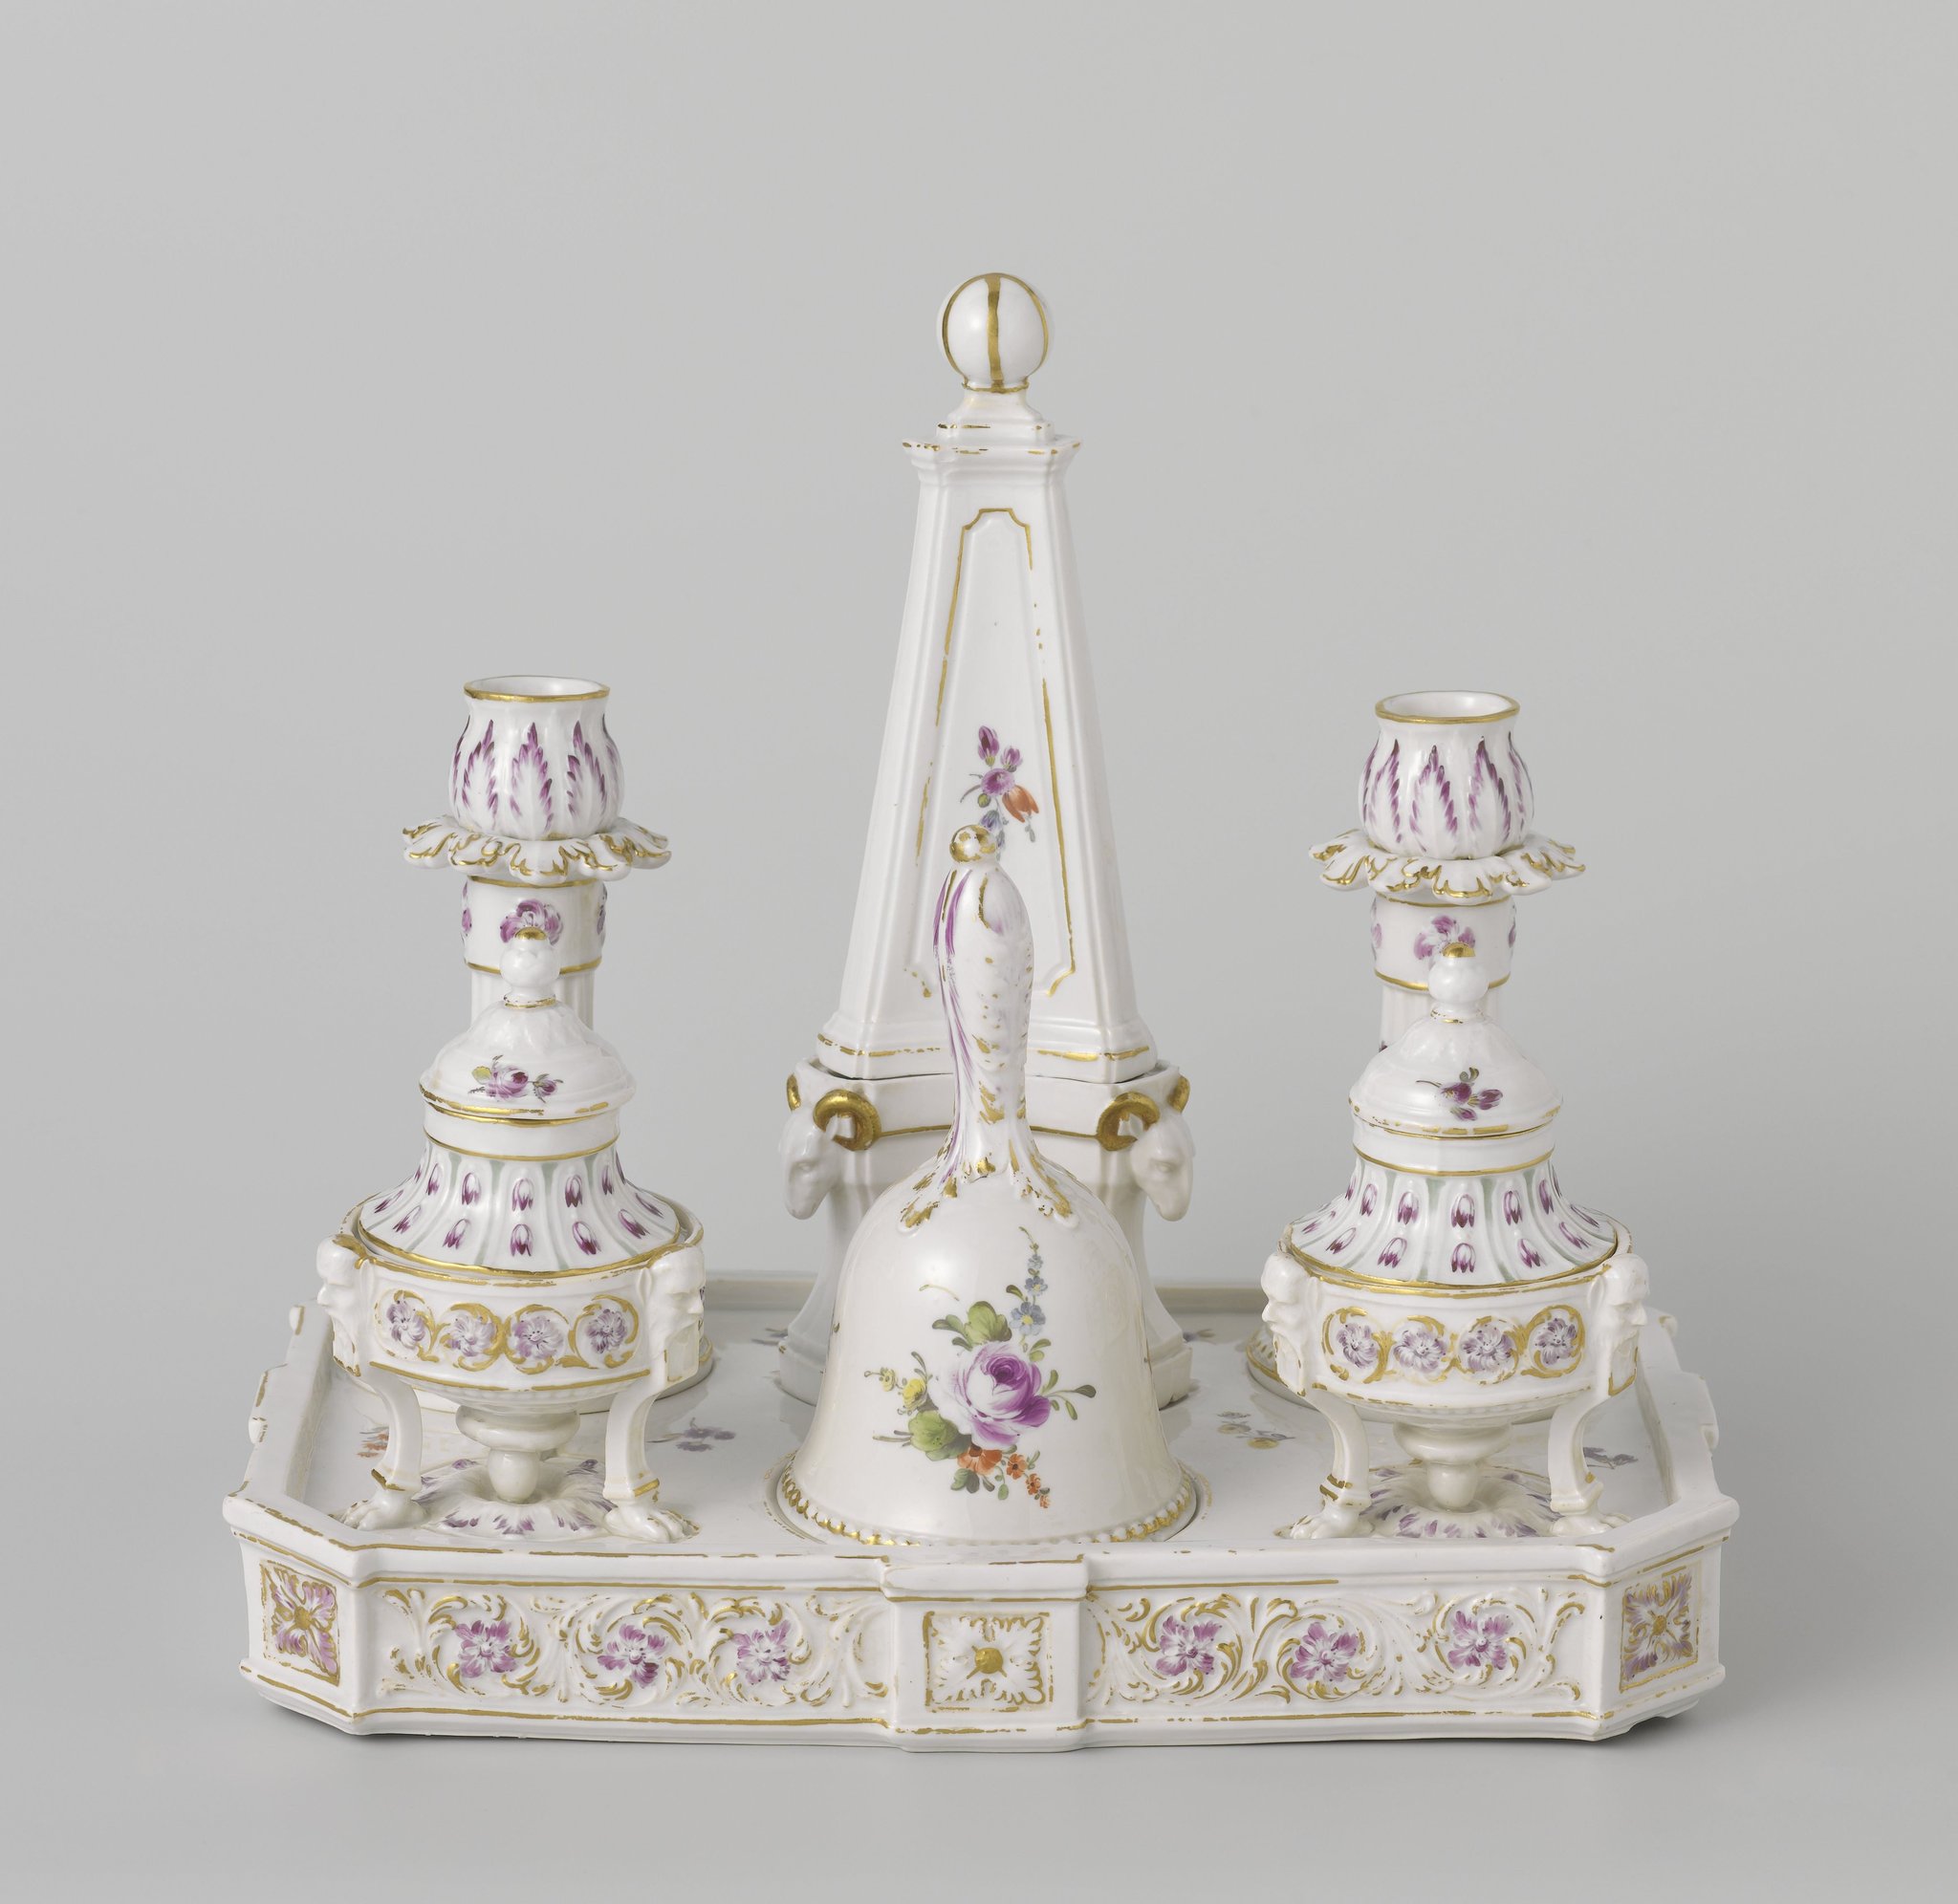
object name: inkstand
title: Inkstand with flower sprays, floral scrolls and petal borders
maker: Anonymous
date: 1777-1790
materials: glaze, gold, paint, porcelain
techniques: firing, forming, gilding, relief, vitrification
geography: the hague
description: Ansbach or Fürstenberg painted decoration: possibly Porseleinfabriek Den Haag, c. 1777–1790 hard-paste porcelain